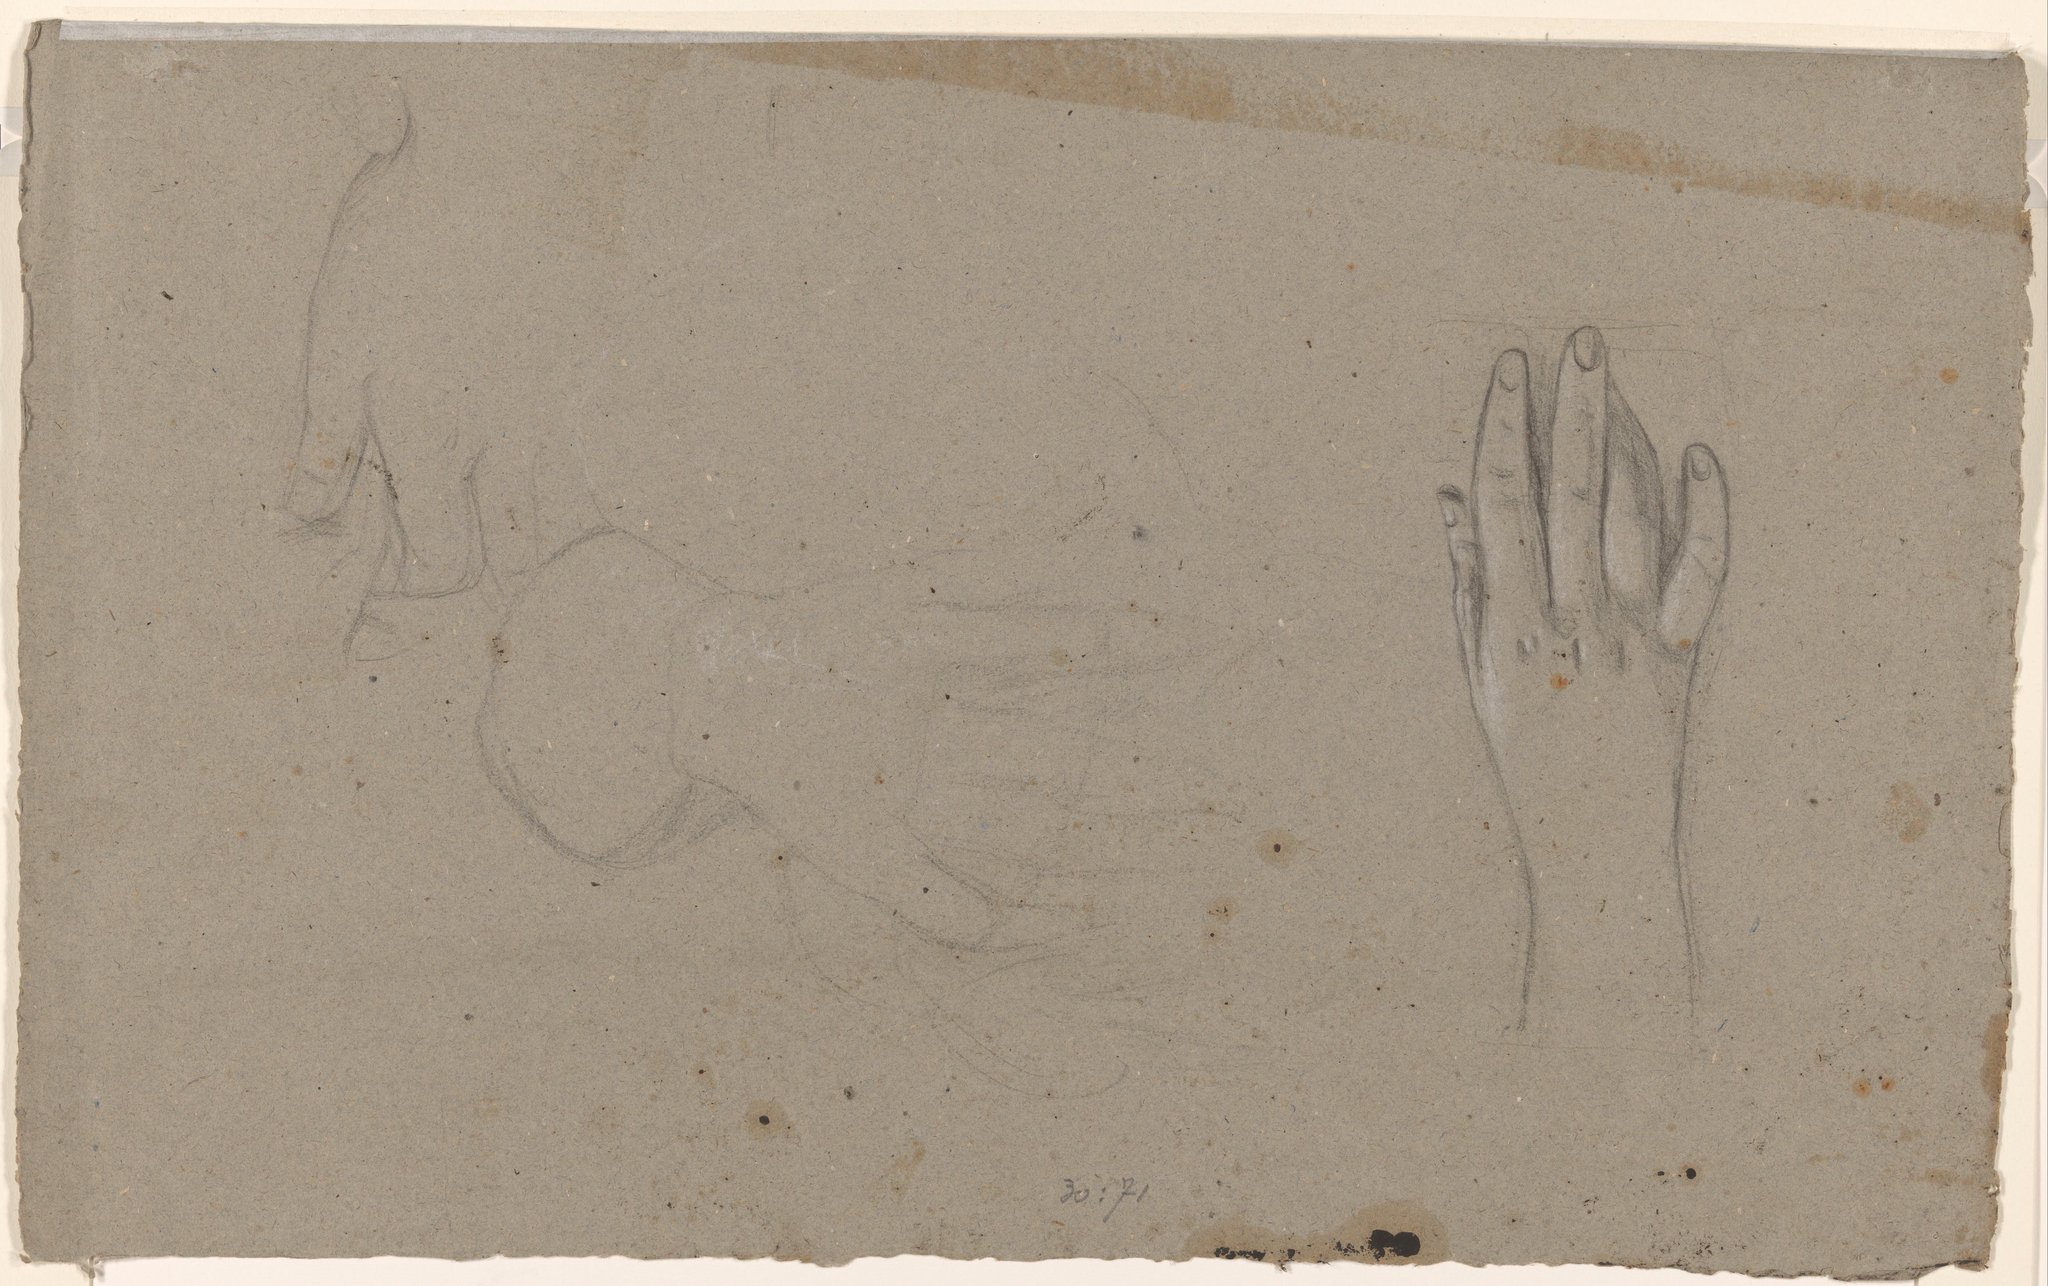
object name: drawing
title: Studies van handen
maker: jan adam kruseman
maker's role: draughtsman, painter, print maker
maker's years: 1804-1862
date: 1814-1862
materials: chalk, paper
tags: hand